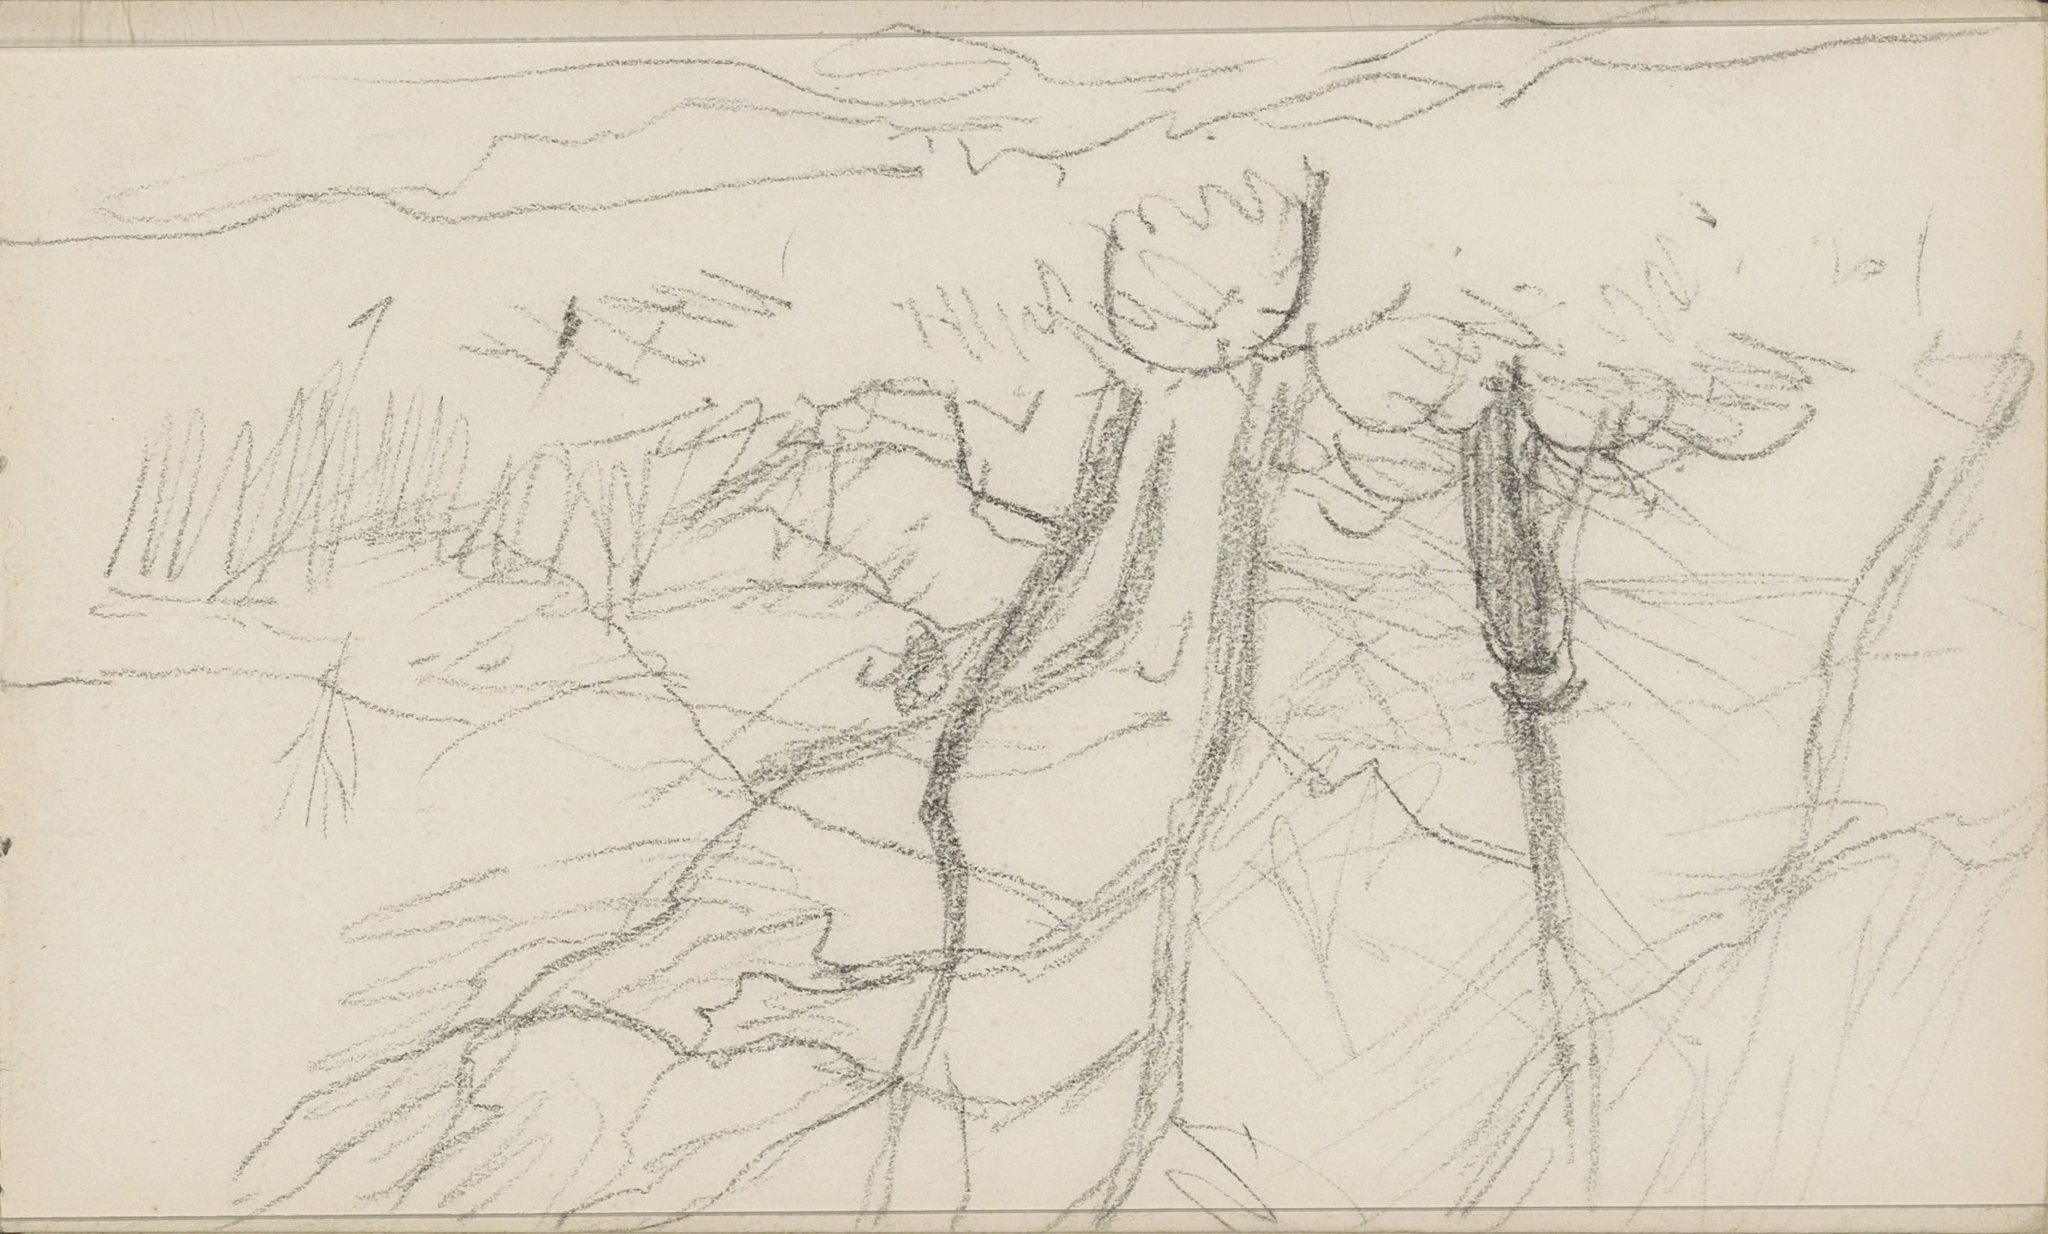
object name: sketchbook leaf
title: Herder met een schaapskudde bij een groep bomen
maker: anton mauve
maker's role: draughtsman, painter, print maker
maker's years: 1838-1888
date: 1848-1888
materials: chalk, paper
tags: herding, herdsman, herdswoman, shepherd, shepherdess, cowherd, etc., sheep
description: Blad 26 recto uit een schetsboek met 33 bladen.